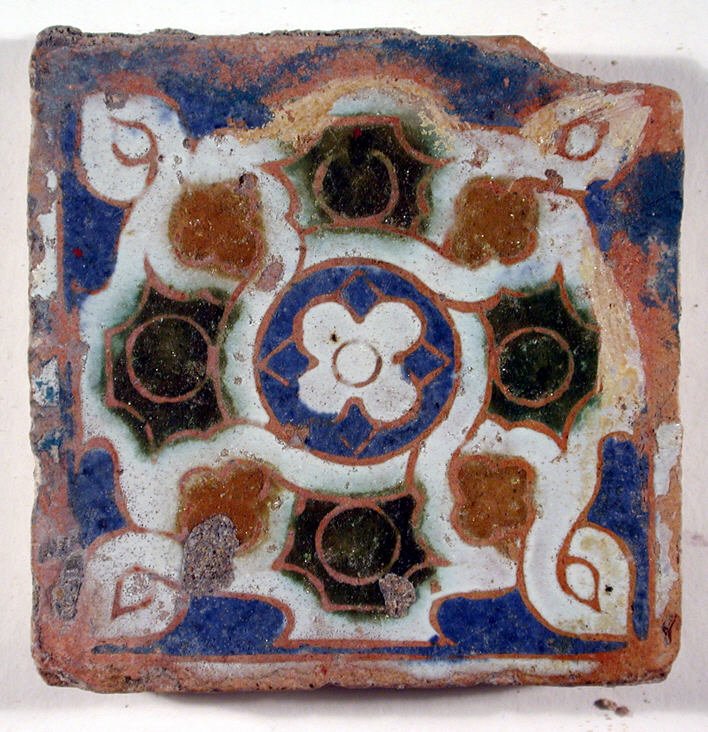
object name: pavement tile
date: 1501-1600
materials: earthenware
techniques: glazing